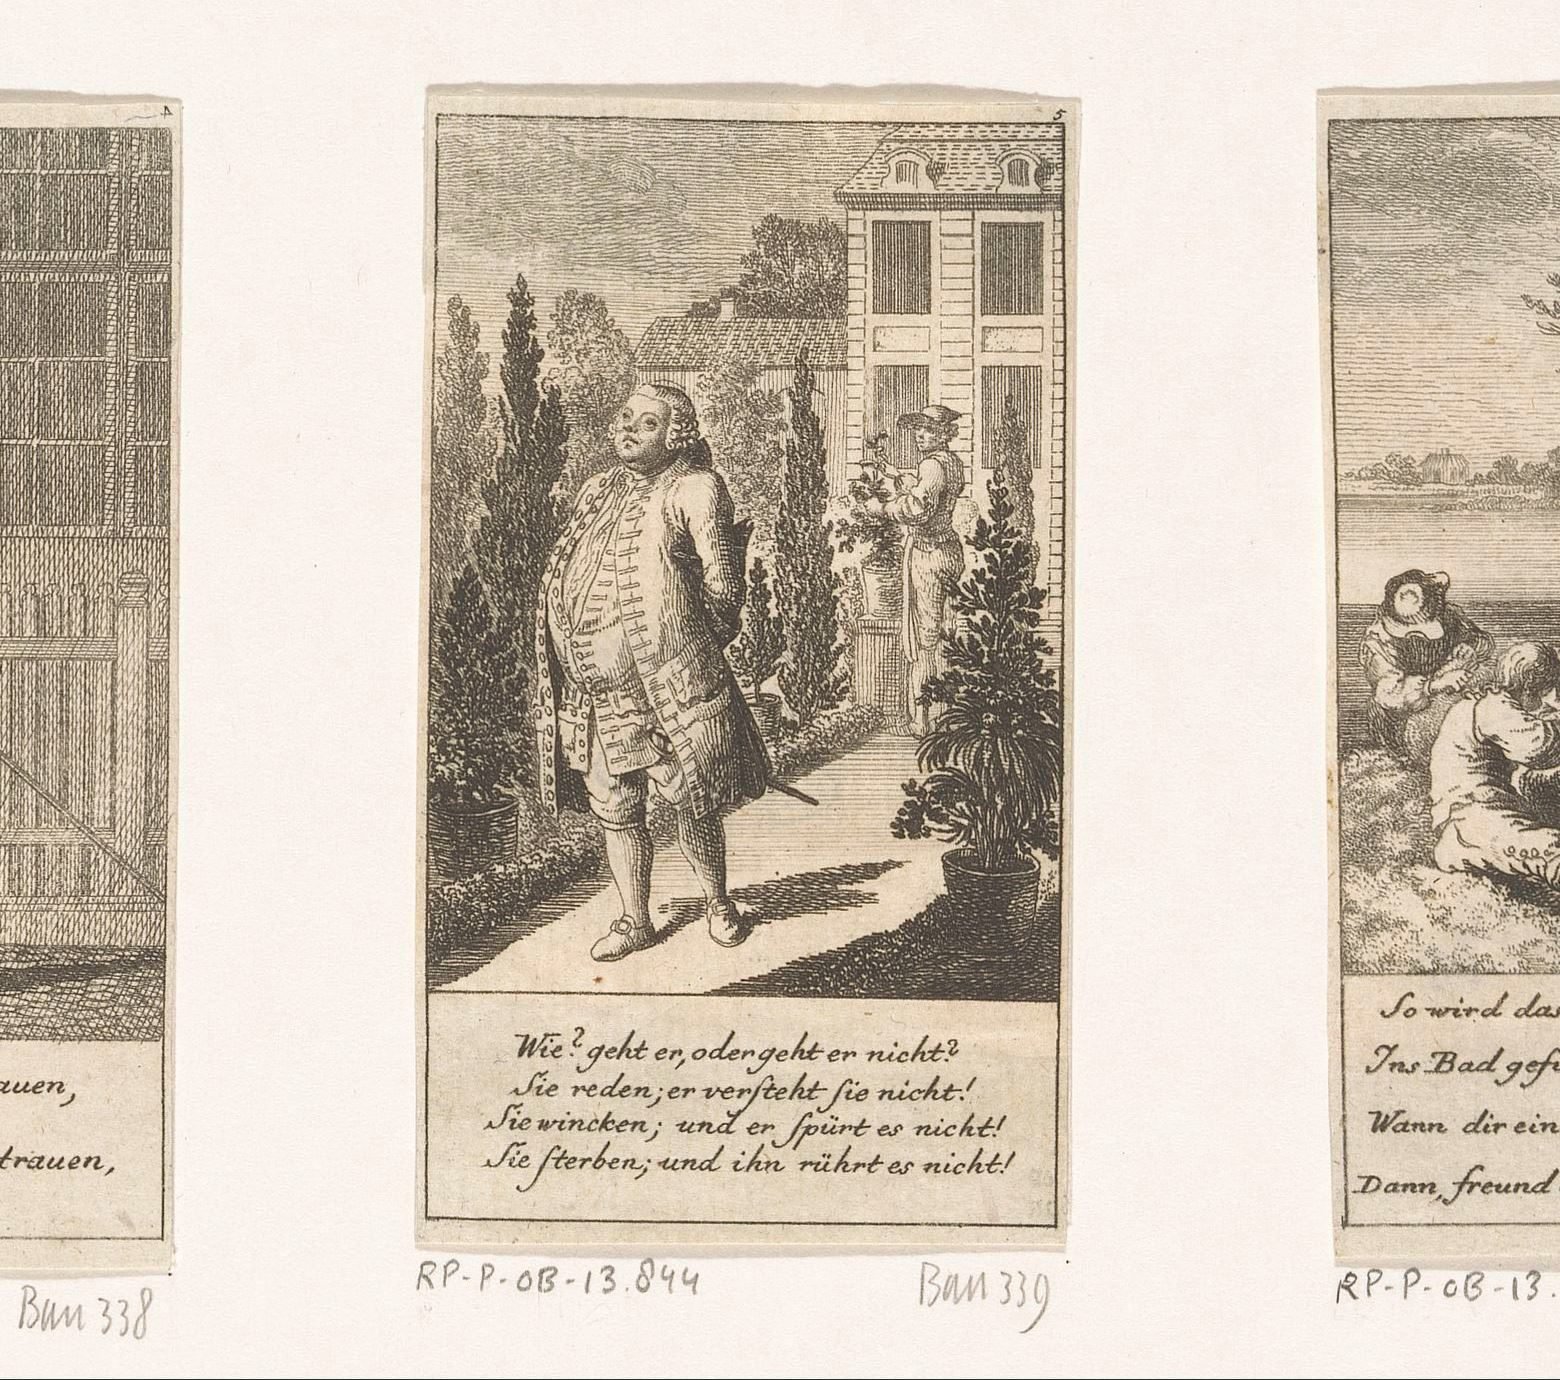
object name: print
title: Mei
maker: daniel nikolaus chodowiecki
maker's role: draughtsman, print maker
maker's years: 1726-1801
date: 1777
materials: paper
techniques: etching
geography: berlin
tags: may and its 'labours'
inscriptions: collector's mark: Lugt 2228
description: Afkomstig uit een serie met de twaalf maanden. Deze serie werd op een plaat geëtst. Deze serie is ook gebruikt in: Königl. Großbrit. Churf. Braunschw. Lüneb. Genealogischen Kalender, auf das Jahr 1778. Lauenburg: Johann Georg Berenberg.